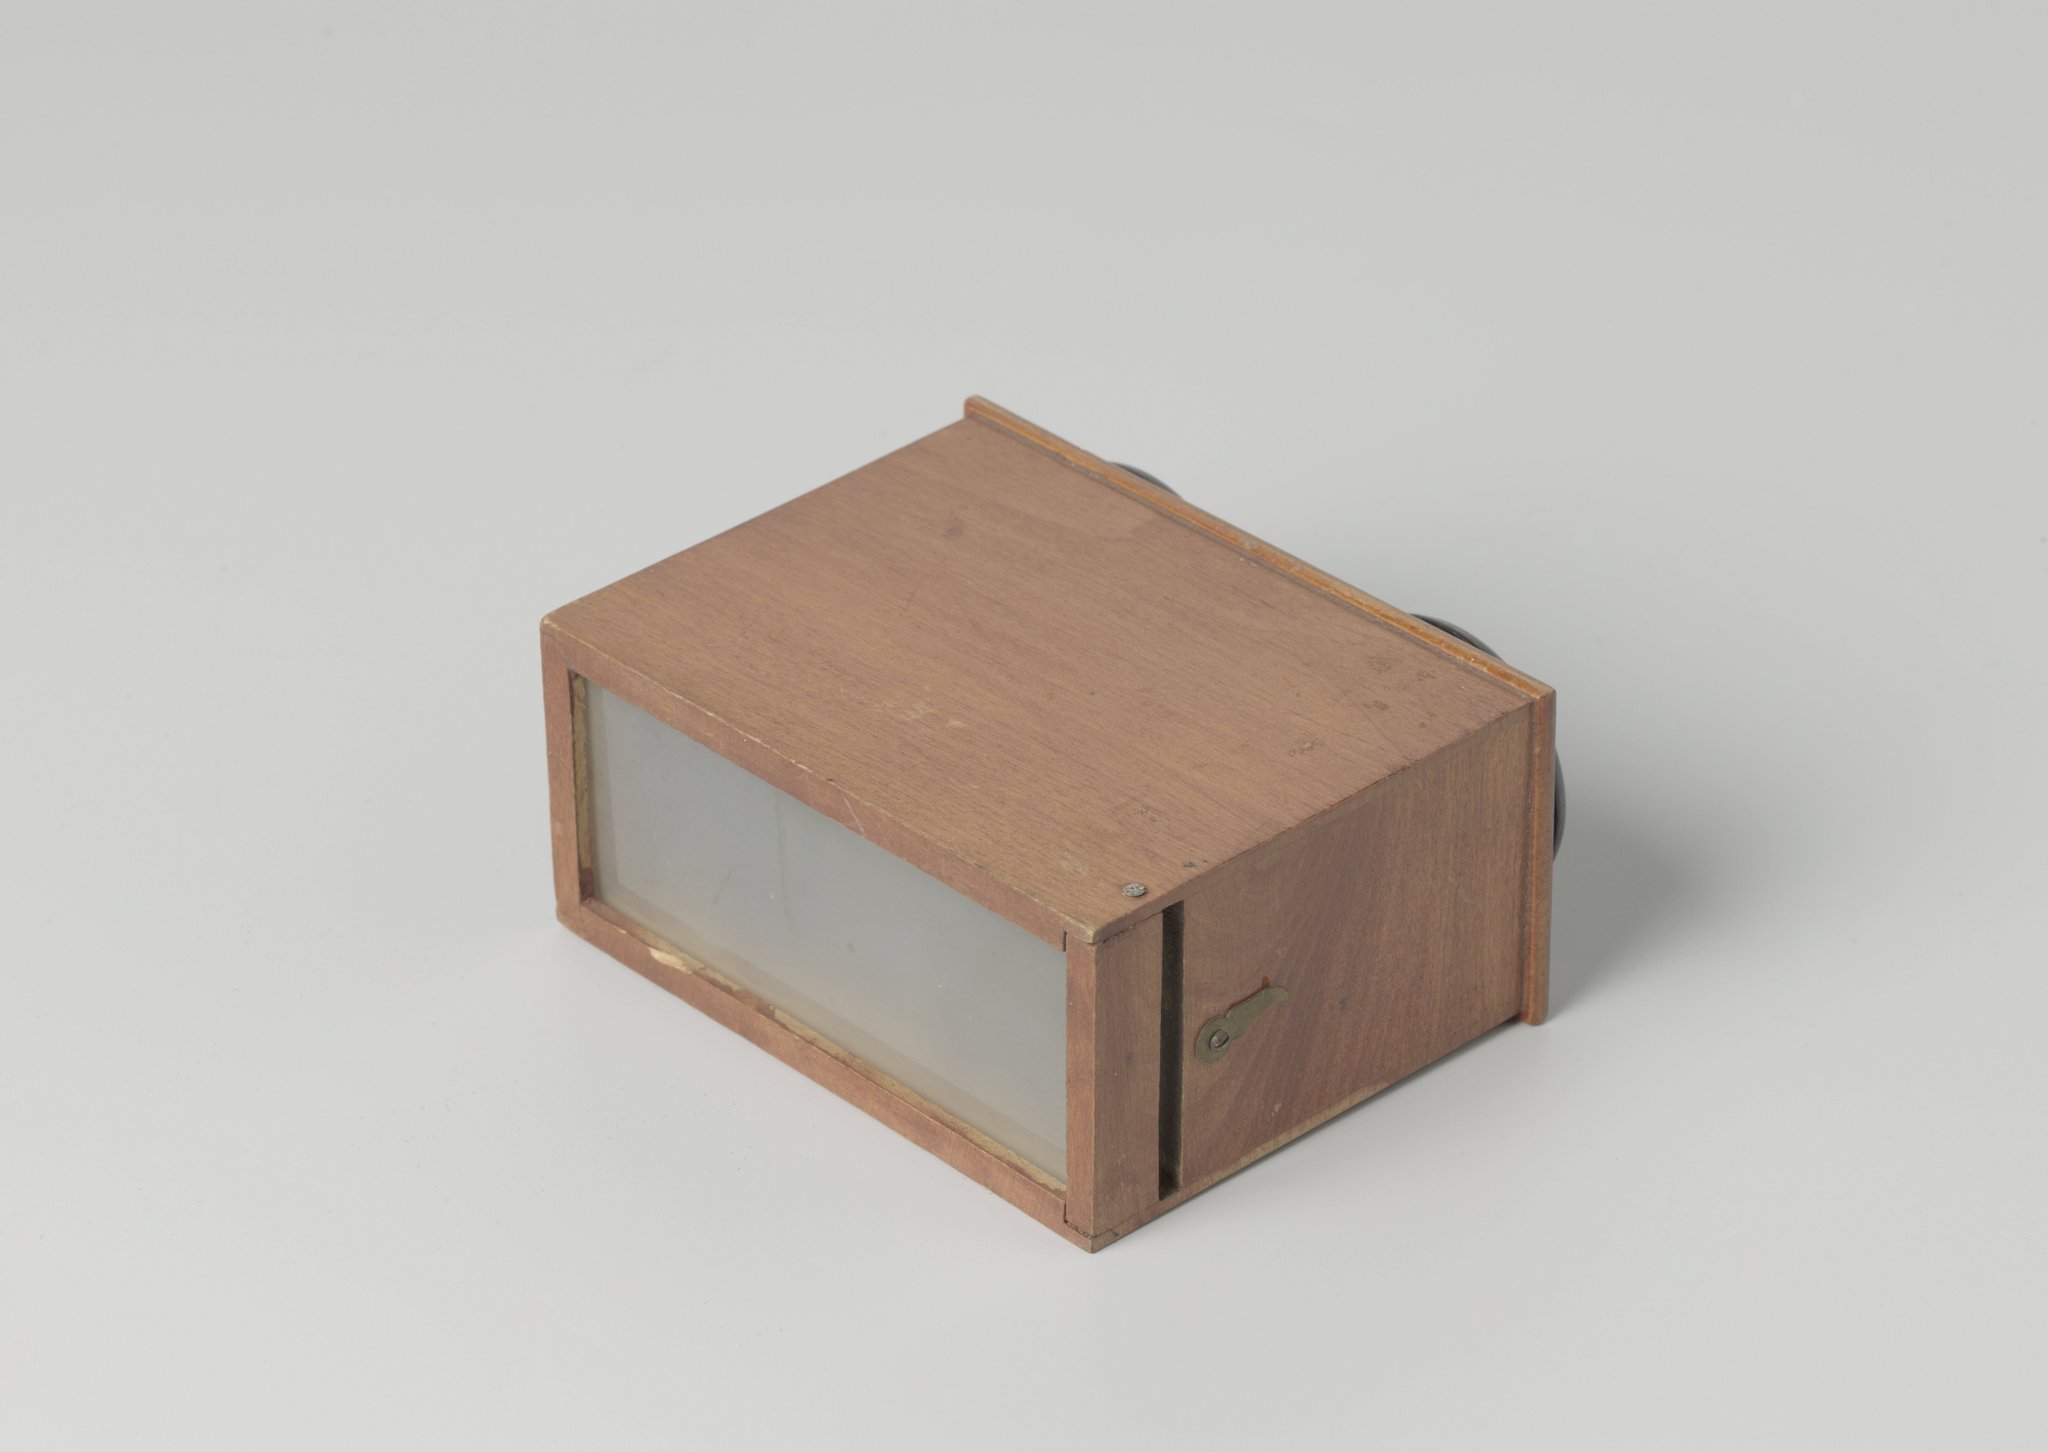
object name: photograph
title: Stereokijker (type Brewster)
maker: Anonymous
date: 1400-1950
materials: glass, metal, wood